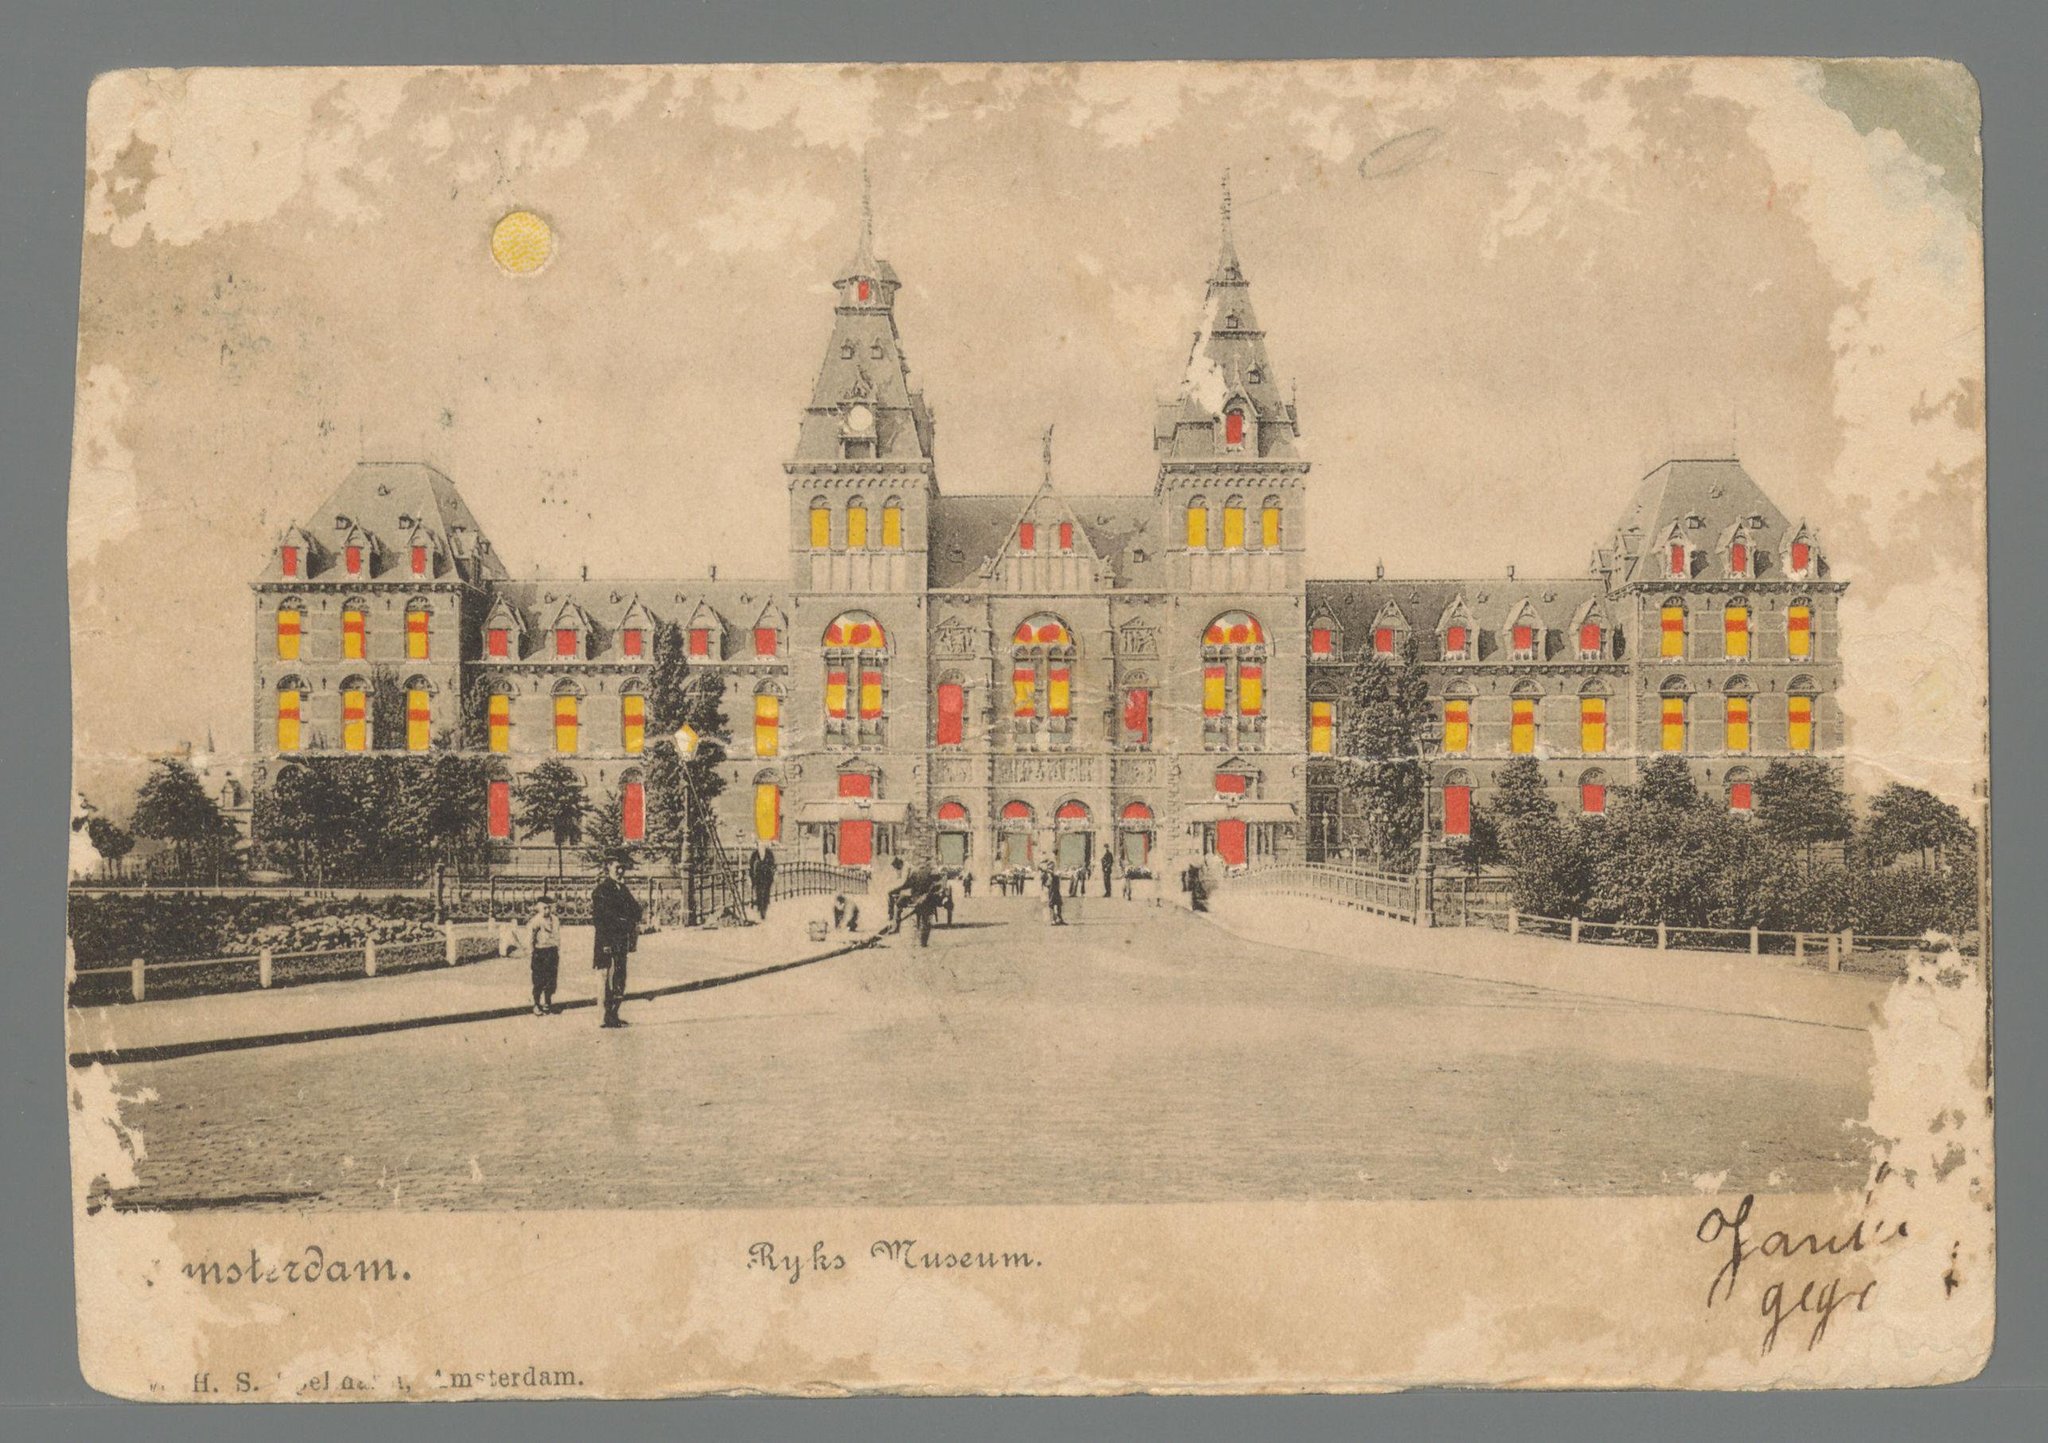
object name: photomechanical print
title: Amsterdam. Rijks Museum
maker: Anonymous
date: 1892-1904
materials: paper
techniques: photograph, snipping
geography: amsterdam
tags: permanent exhibition, museum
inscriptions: inscription: ‘BRIEFKAART / (CARTE POSTALE.) / ALGEMEENE POST [rest onleesbaar] / POSTALE UNIVERSELLE) / [etc.]’, inscription: ‘Amsterdam. / Rijks Museum. / [naam uitgever onleesbaar]’